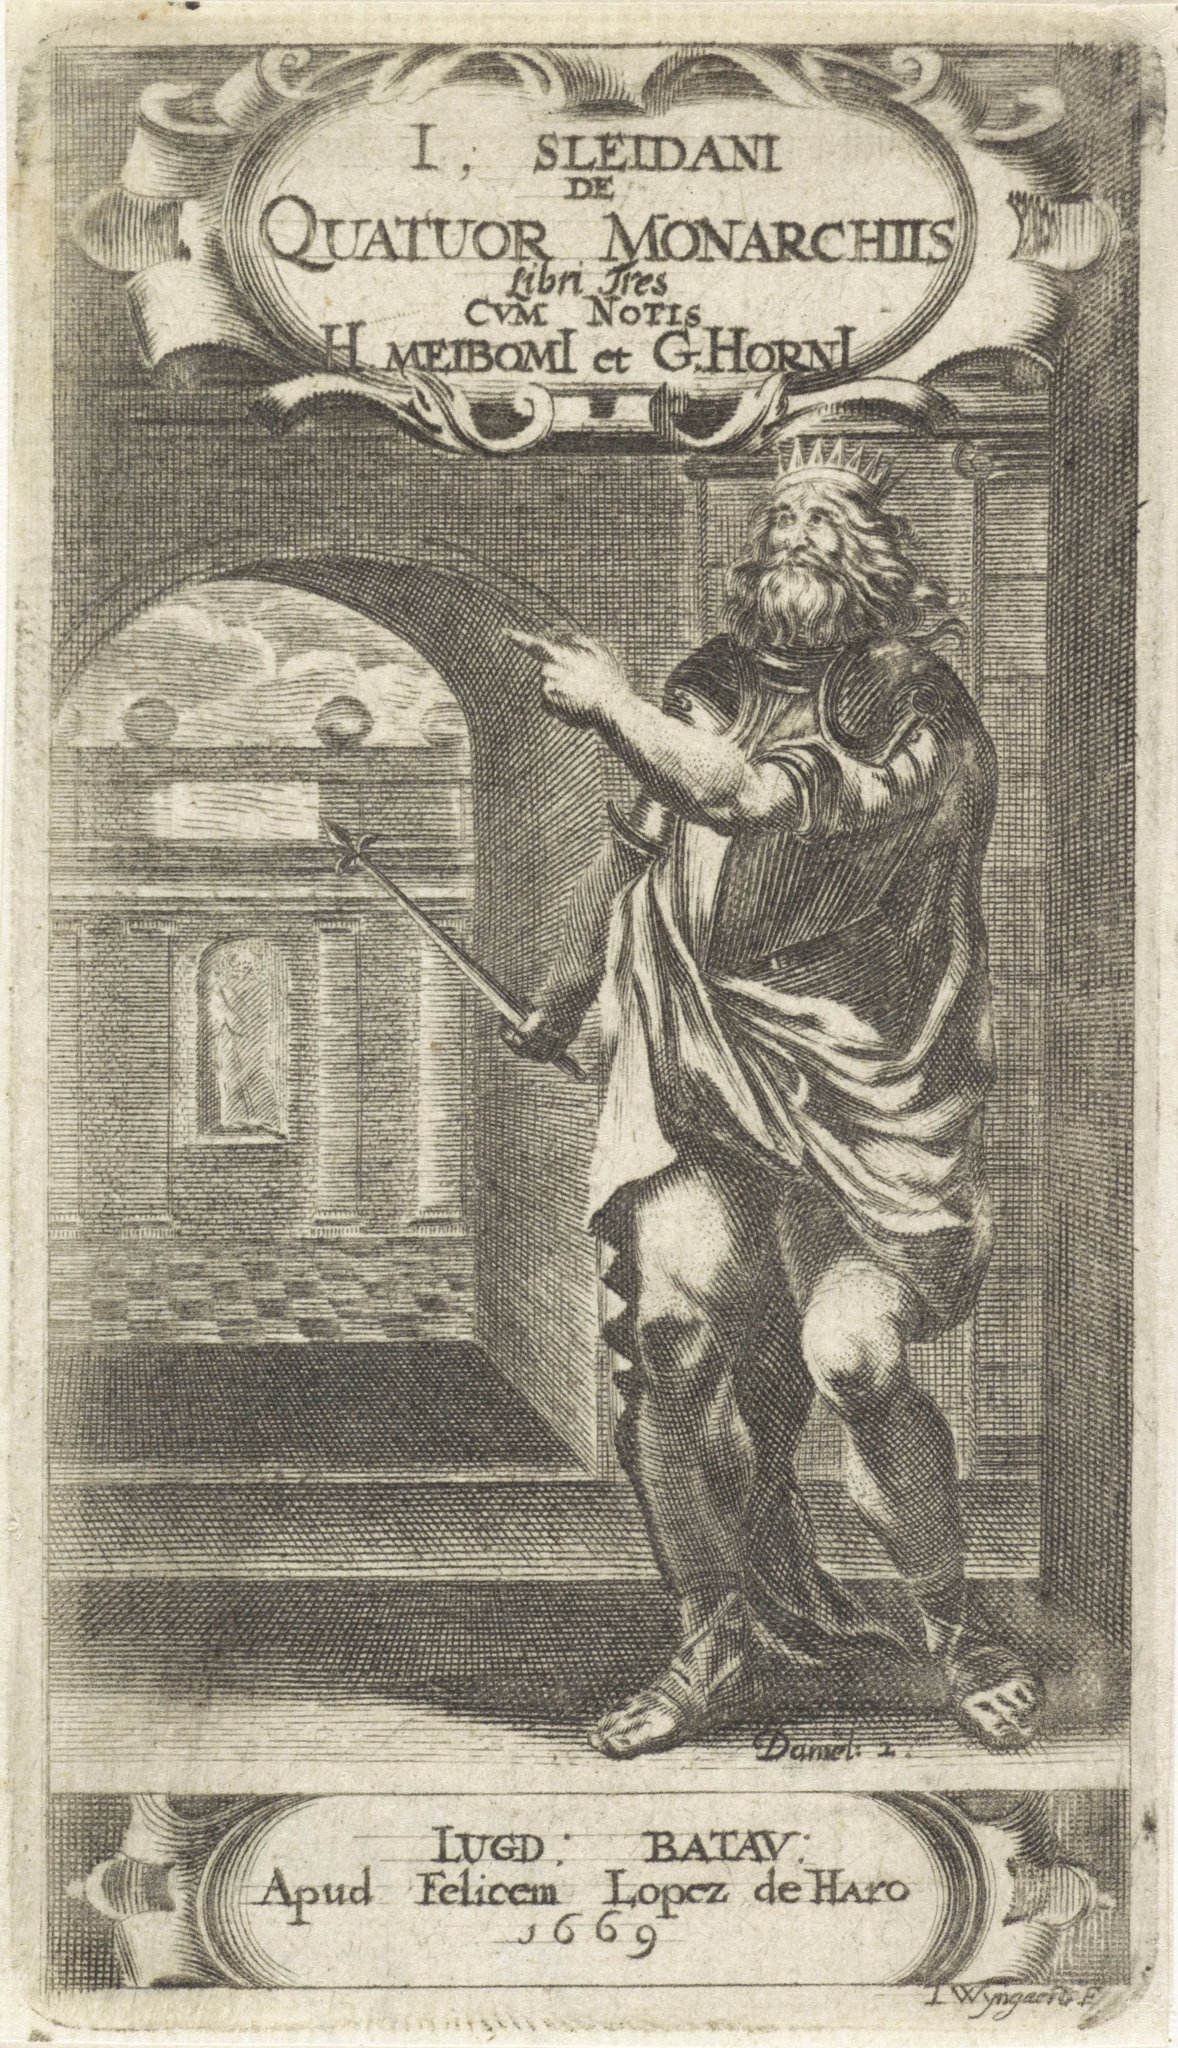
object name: titelblad, titelpagina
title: Koning Nebukadnessar in zijn paleis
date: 1669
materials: paper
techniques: engraving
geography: leiden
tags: daniel and king nebuchadnezzar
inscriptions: collector's mark: Lugt 2228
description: Koning Nebukadnessar, met een scepter in de hand, wijst naar een doorgang in zijn paleis. Onder zijn voeten een verwijzing naar het Bijbelverhaal Dan. 2. Bovenaan in een cartouche de titel in het Latijn. Onderaan in een cartouche het impressum.